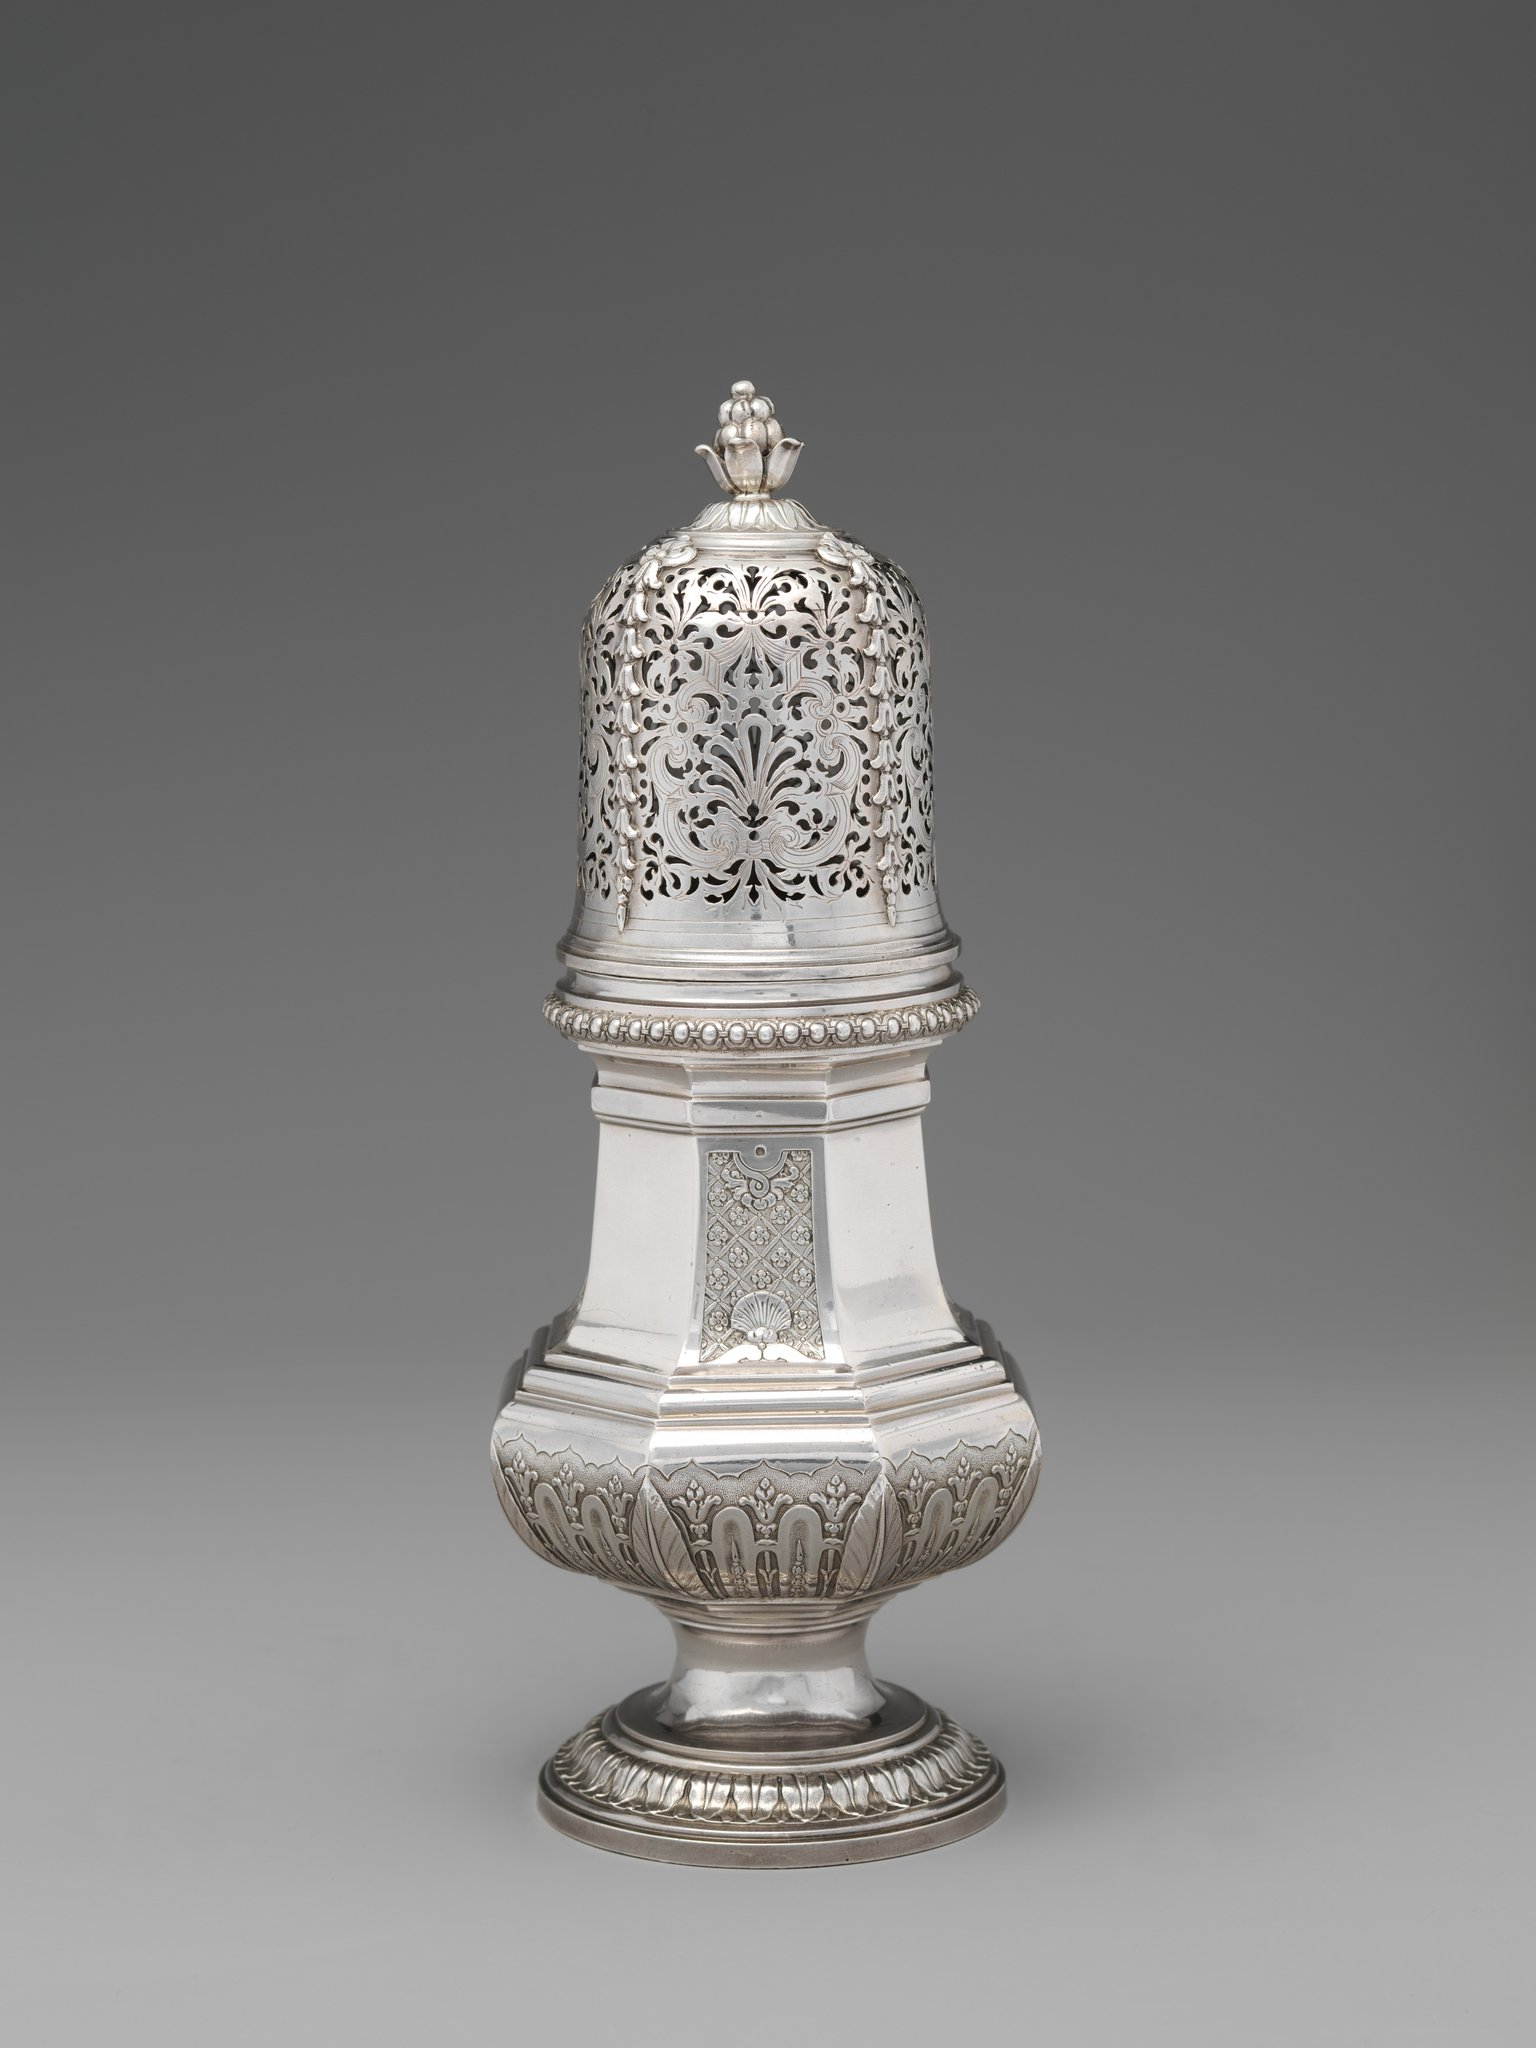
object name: sugar caster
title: Sugar caster (one of a pair)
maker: nicolas besnier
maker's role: maker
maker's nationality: french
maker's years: 1686-1754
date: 1728-1729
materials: silver